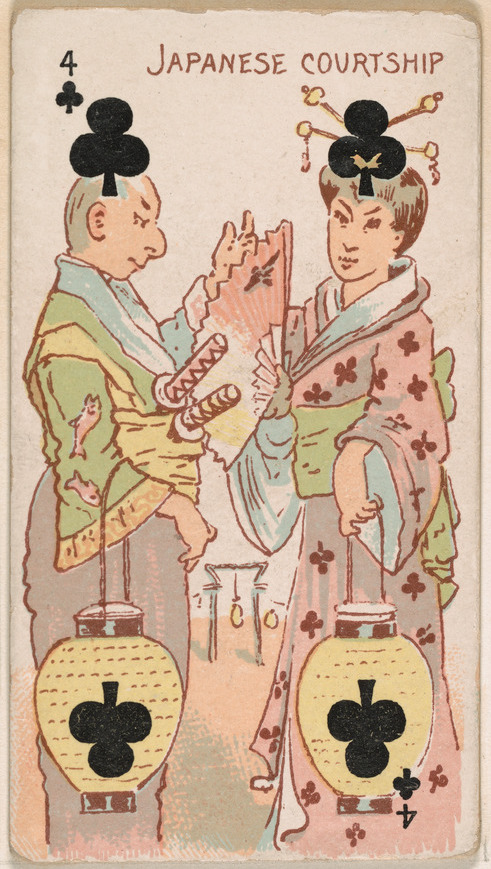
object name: print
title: Four of Clubs, Japanese Courtship, from Harlequin Cards, 2nd Series (N220) issued by Kinney Bros.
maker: kinney brothers tobacco company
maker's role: publisher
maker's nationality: american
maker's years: 1869-2011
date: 1889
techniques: color lithograph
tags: men,women,playing cards